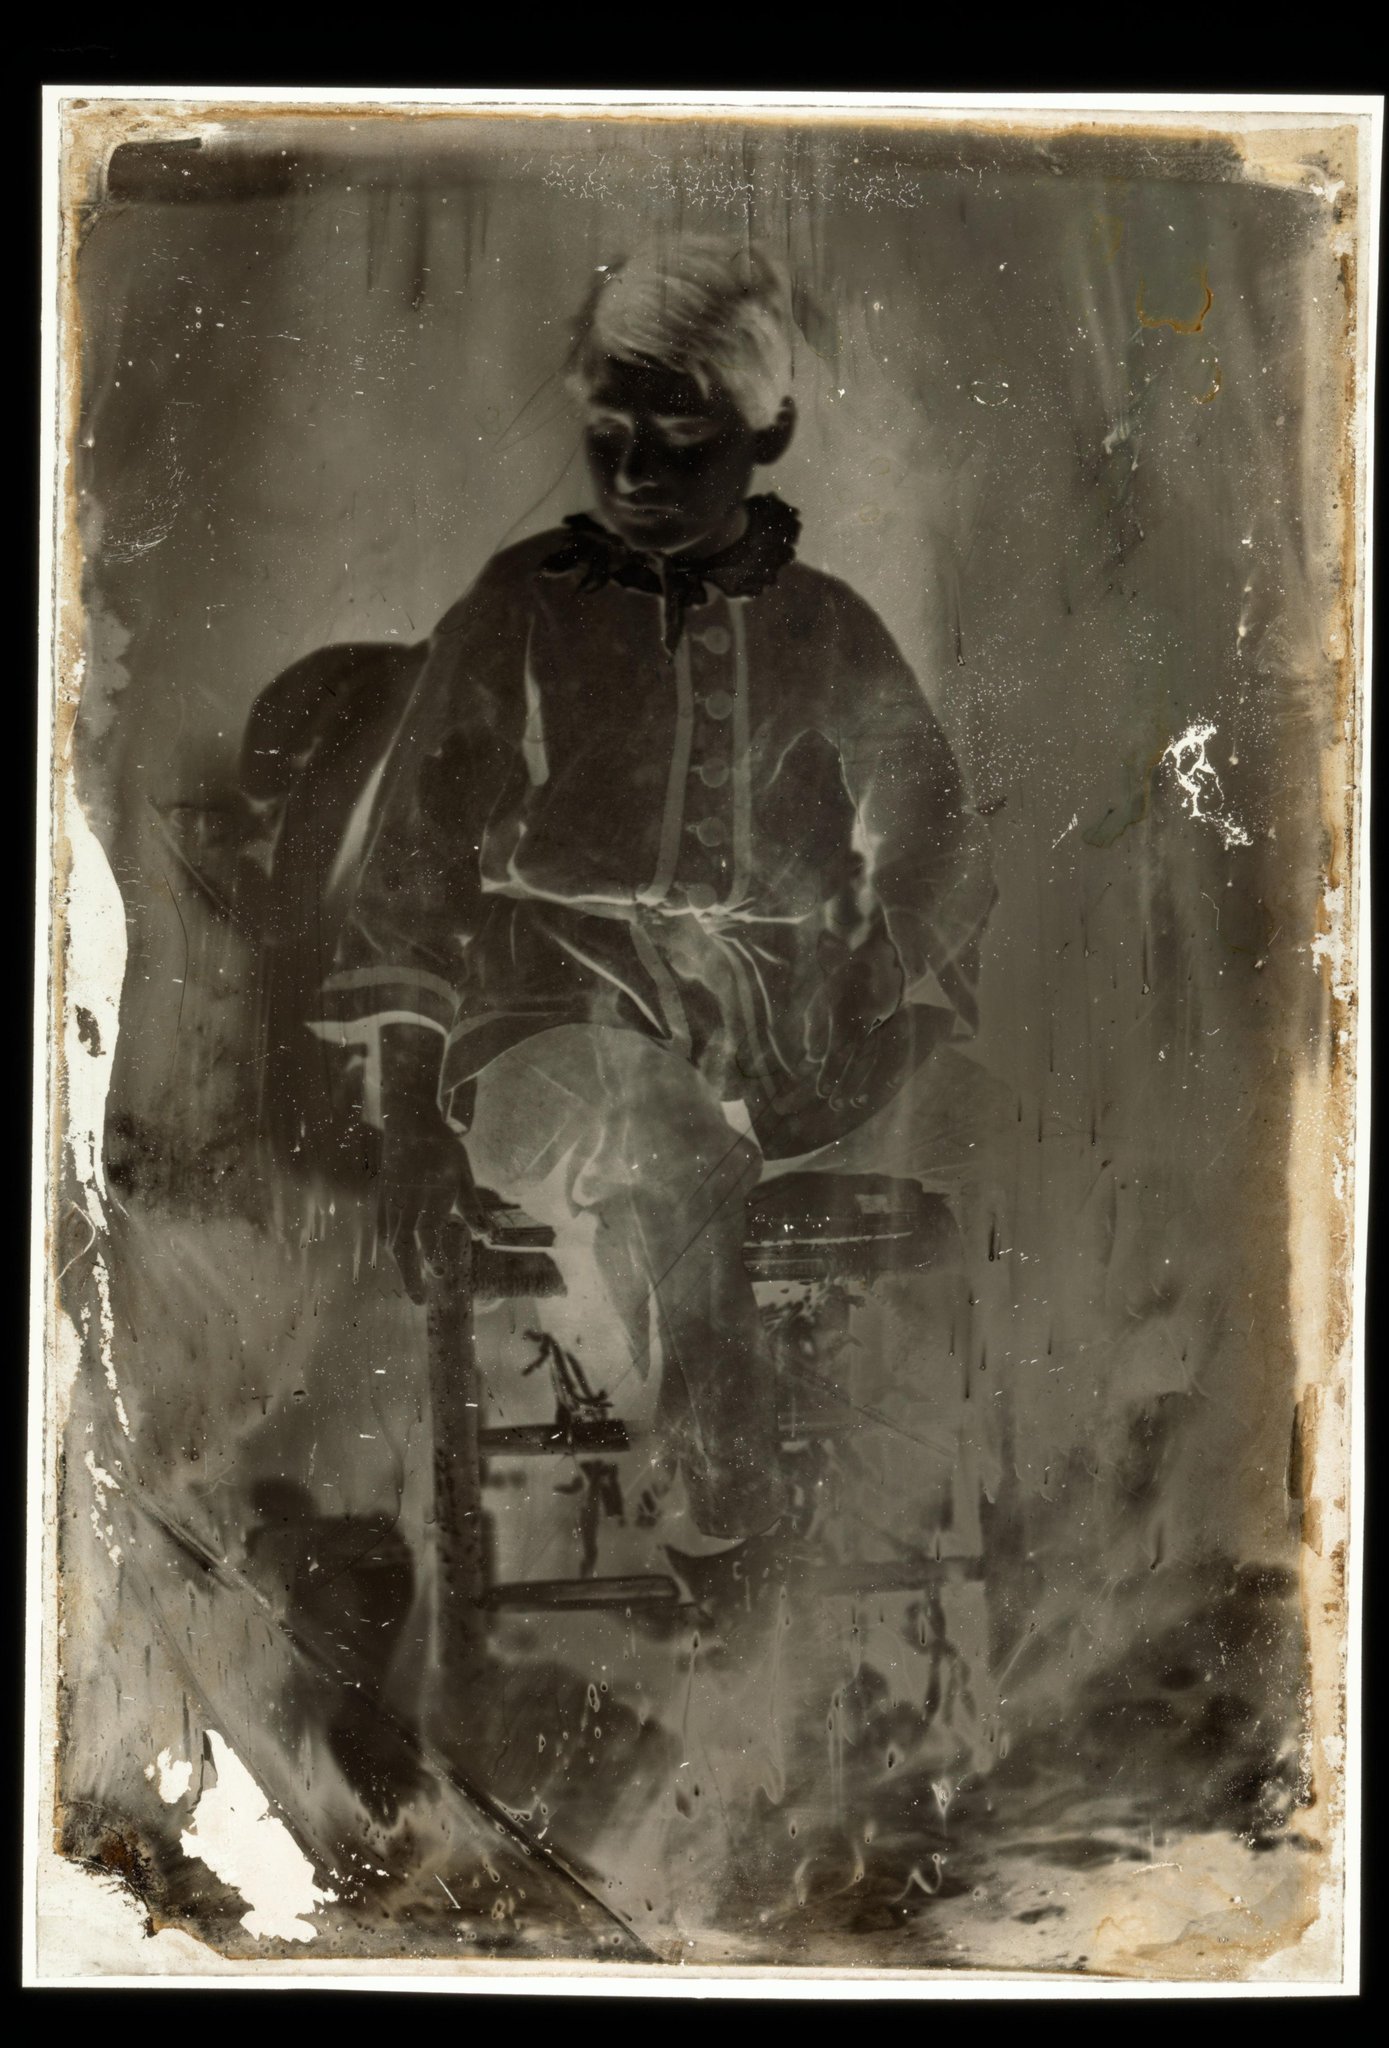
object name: glasnegatief, glasplaatnegatief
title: Portret van een onbekende jongen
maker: laurens lodewijk kleijn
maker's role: draughtsman, painter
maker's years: 1826-1909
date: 1865-1900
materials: glass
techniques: collodion process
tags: boy (child between toddler and youth), anonymous historical person portrayed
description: Onderdeel van een groep glasnegatieven uit de nalatenschap van de schilder Laurens Lodewijk Kleijn, met stillevens, portretten, zelfportretten en kunstreproducties.